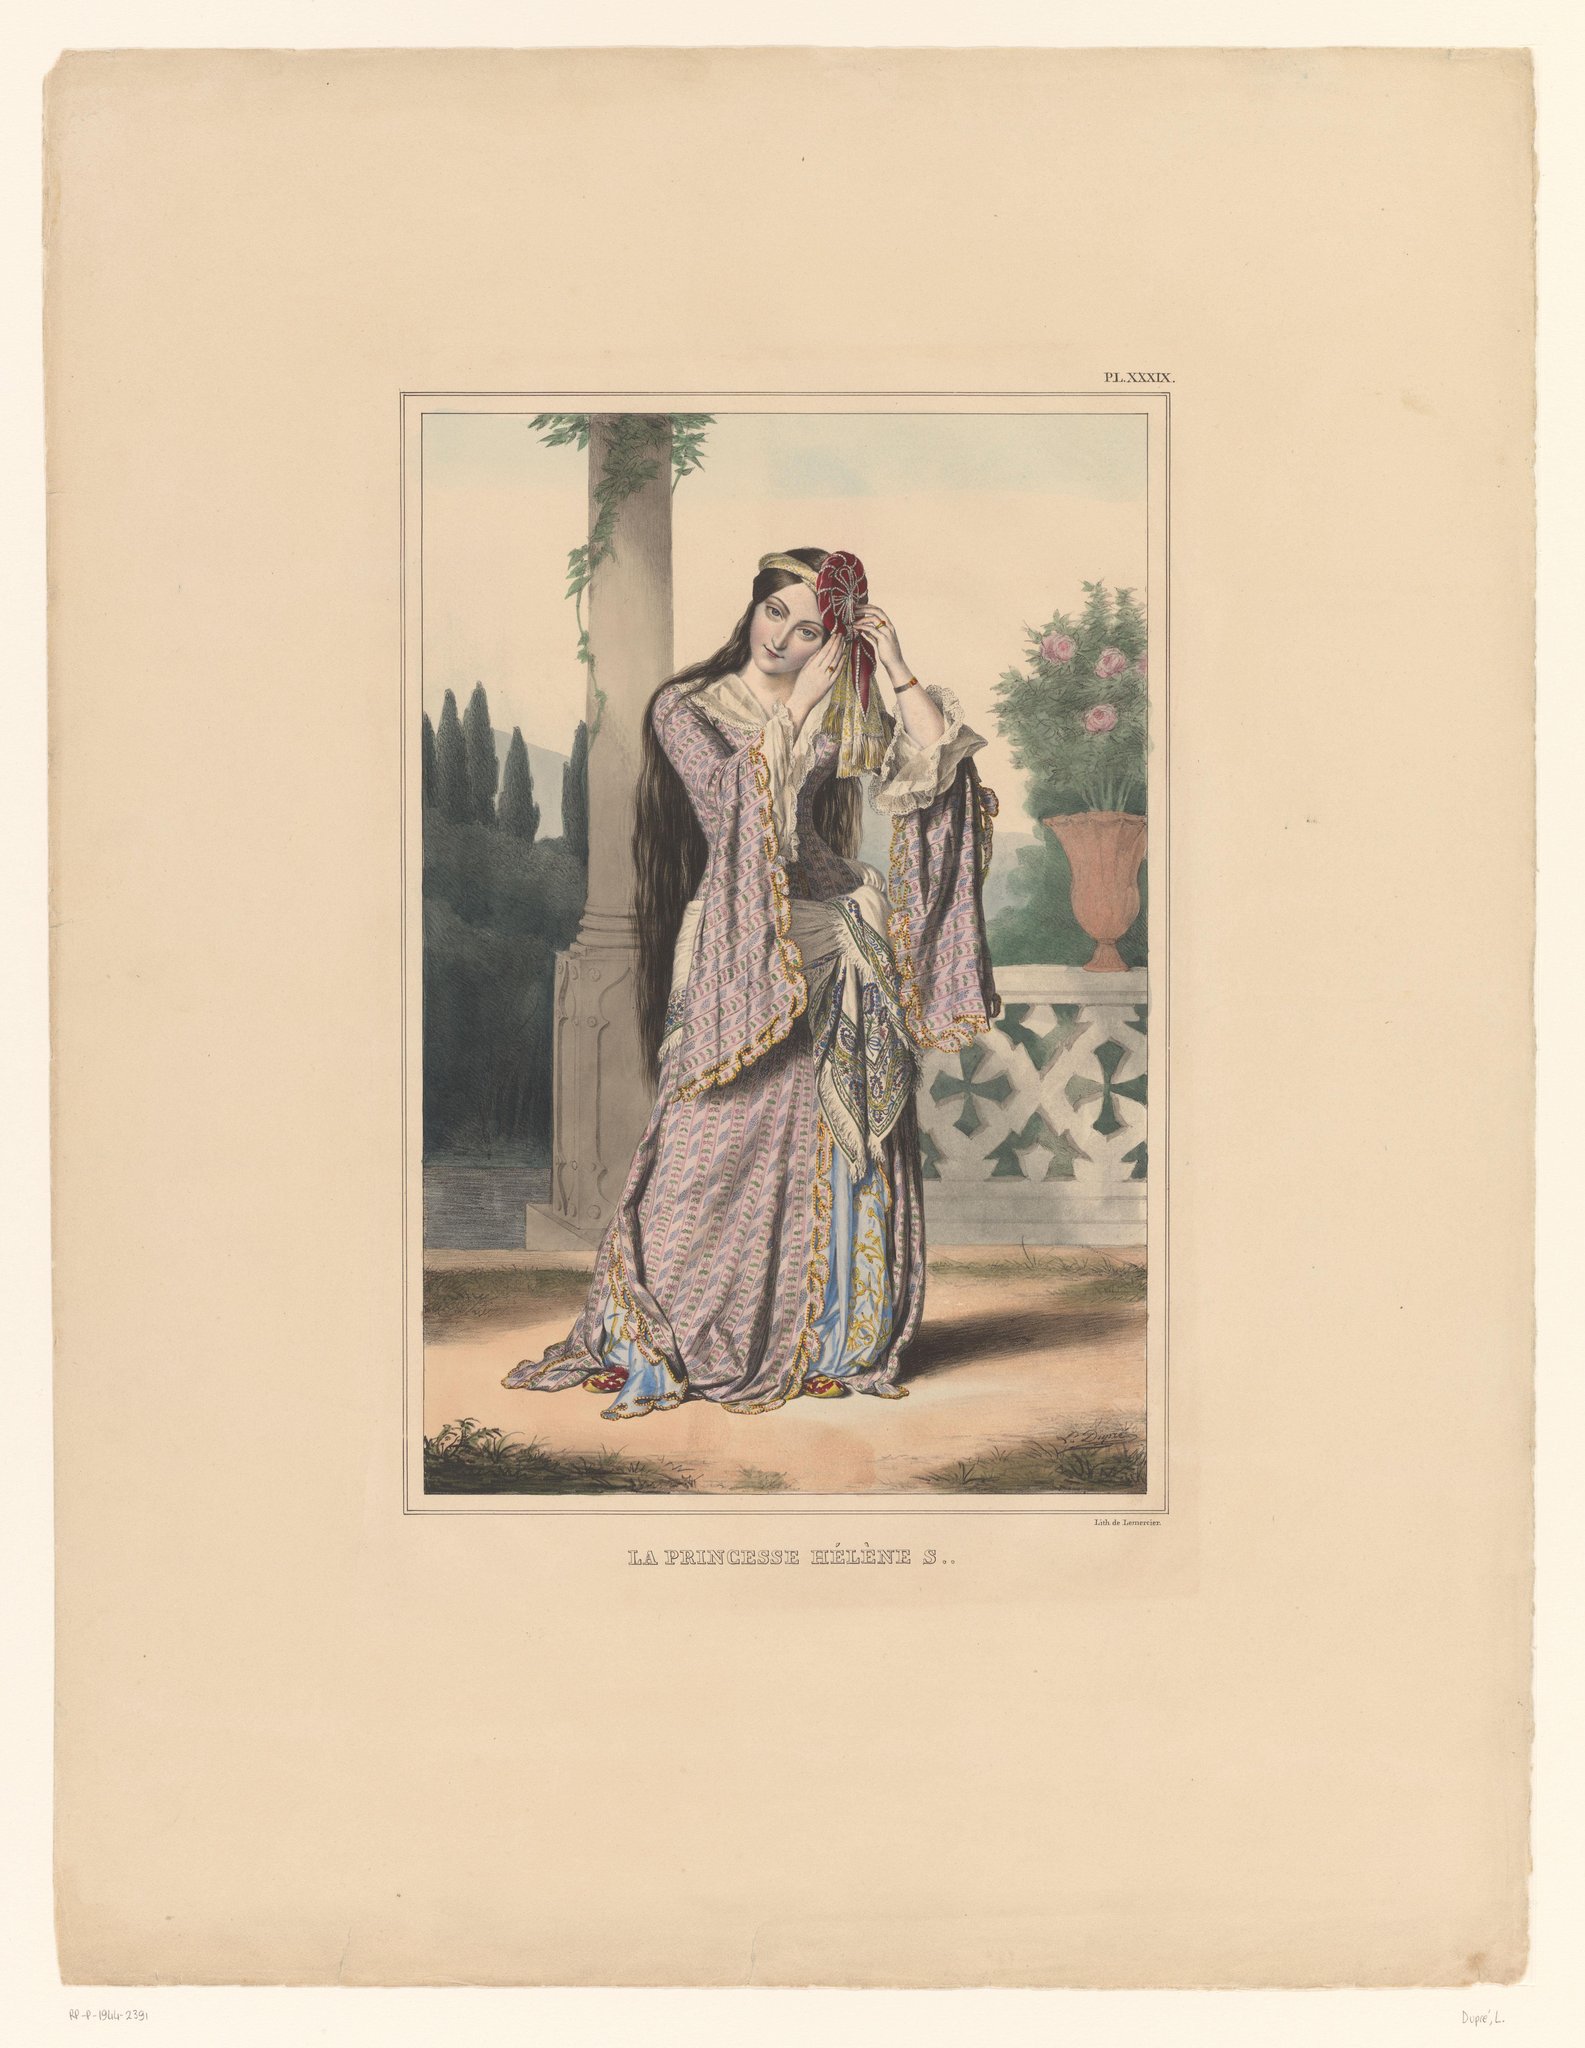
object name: print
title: La princesse Hélène S.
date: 1828-1839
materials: paper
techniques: hand coloring, lithograph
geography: paris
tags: historical persons - bb - woman, historical costume, princess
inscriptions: collector's mark: Lugt 2228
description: De prent maakt deel uit van de serie 'Voyage à Athènes et à Constantinople ou collection de portraits, de vues et de costumes Grecs et Ottomans' die tussen 1825 en 1839 in tien delen van vier prenten werd uitgebracht. De in totaal veertig prenten dienden samen met een tekst van 52 pagina's voorzien van vignettes als een verslag van de reis die Louis Dupré in 1819 naar Athene en het huidige Istanboel maakte (zie documentatie).